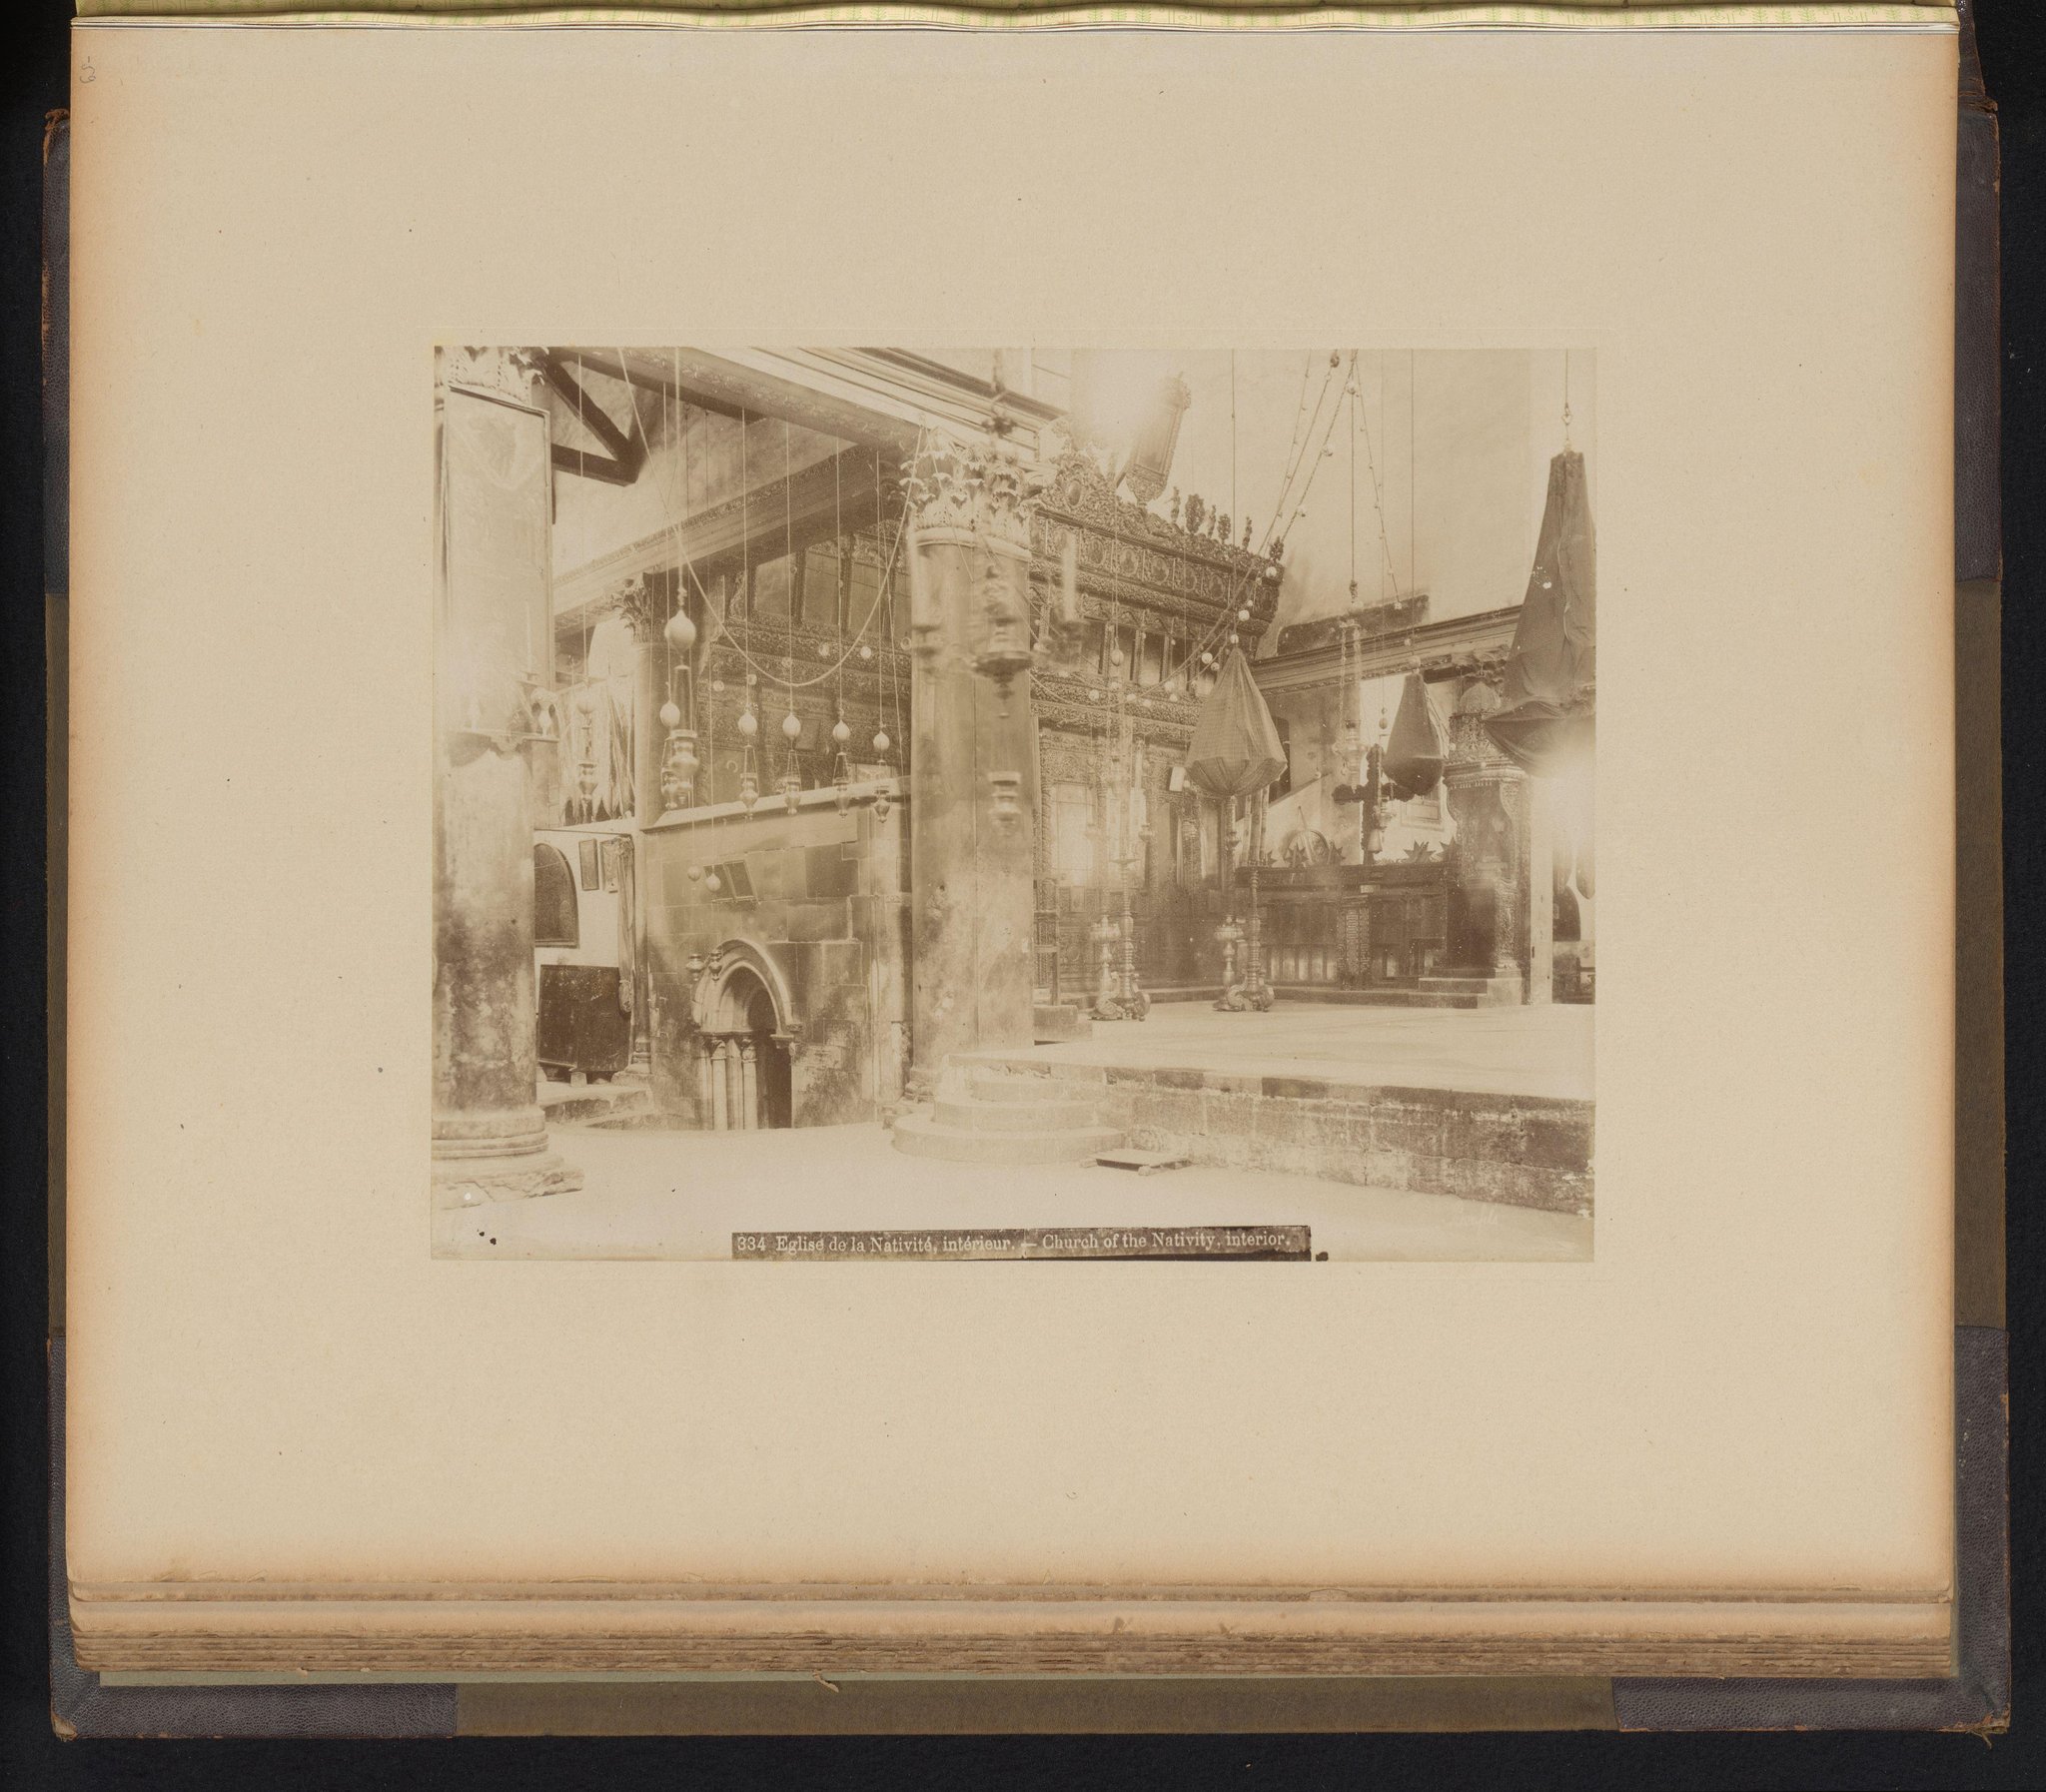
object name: photograph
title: Interieur van de Geboortekerk in Bethlehem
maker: félix bonfils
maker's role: fotograaf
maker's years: 1831-1885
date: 1867-1885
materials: paper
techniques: albumen print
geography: bethlehem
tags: interior of church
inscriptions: number: ‘334’